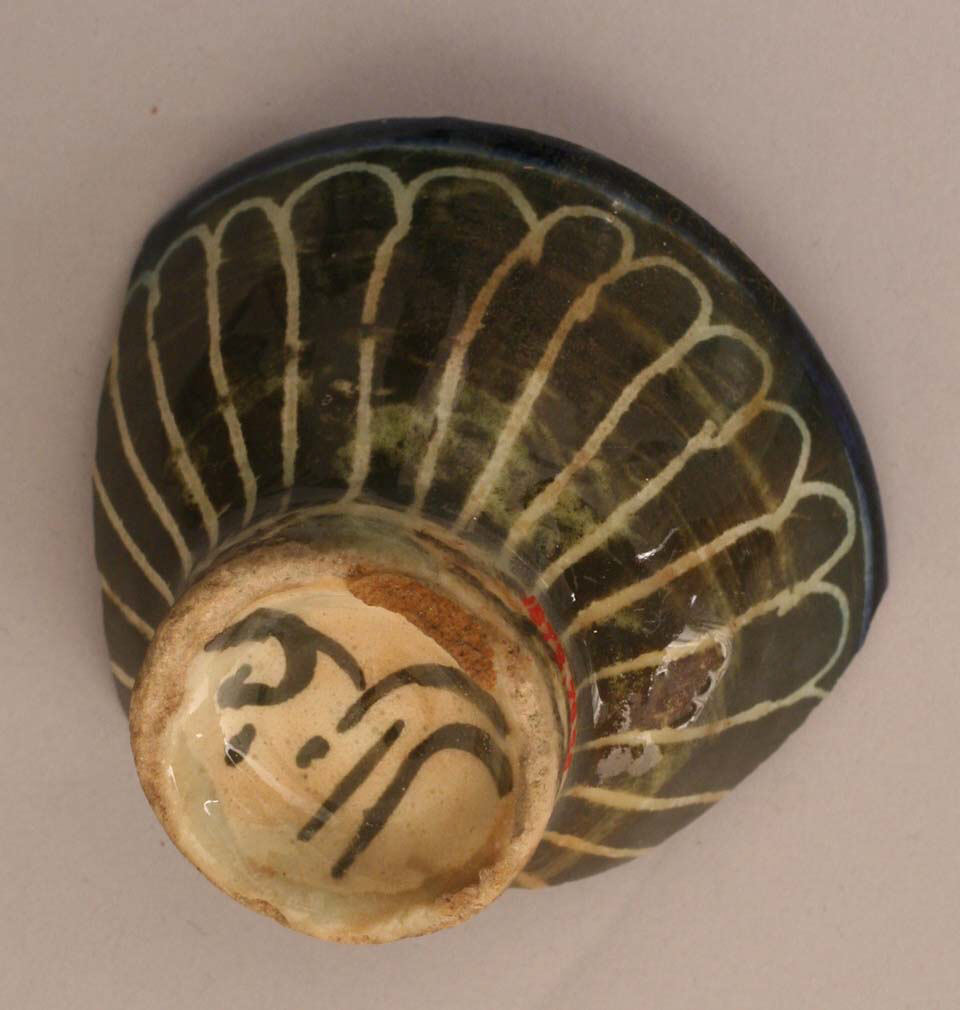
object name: fragment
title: Fragment of a Cup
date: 1201-1600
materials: glaze, stonepaste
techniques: painting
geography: egypt